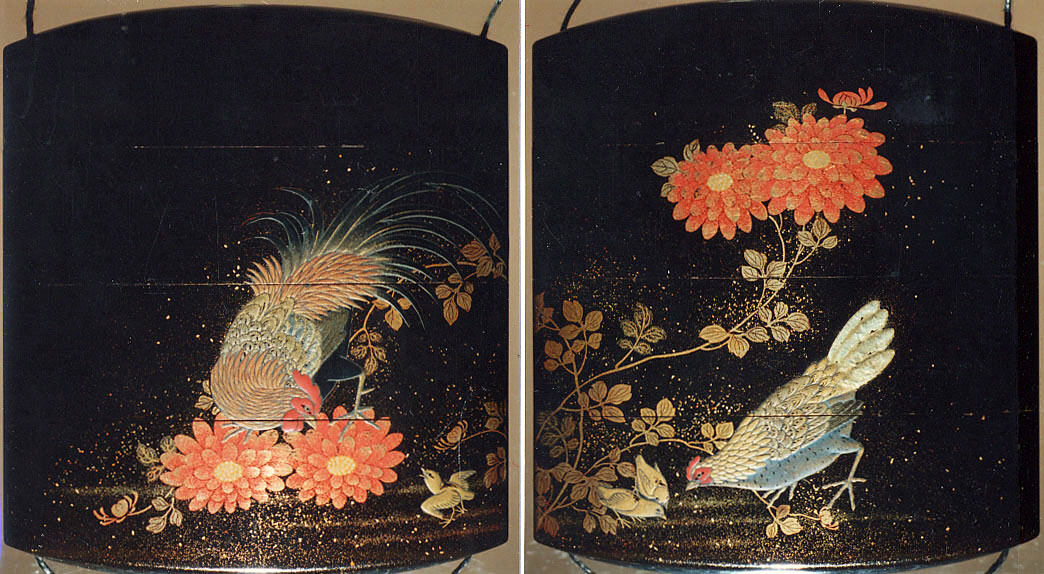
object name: inrō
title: Case (Inrō) with Design of Rooster, Hen and Chicks beside Flowering Chrysanthemums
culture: japanese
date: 1801-1900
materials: gold, lacquer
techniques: fundame, hiramakie, roiro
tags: chickens,roosters,flowers